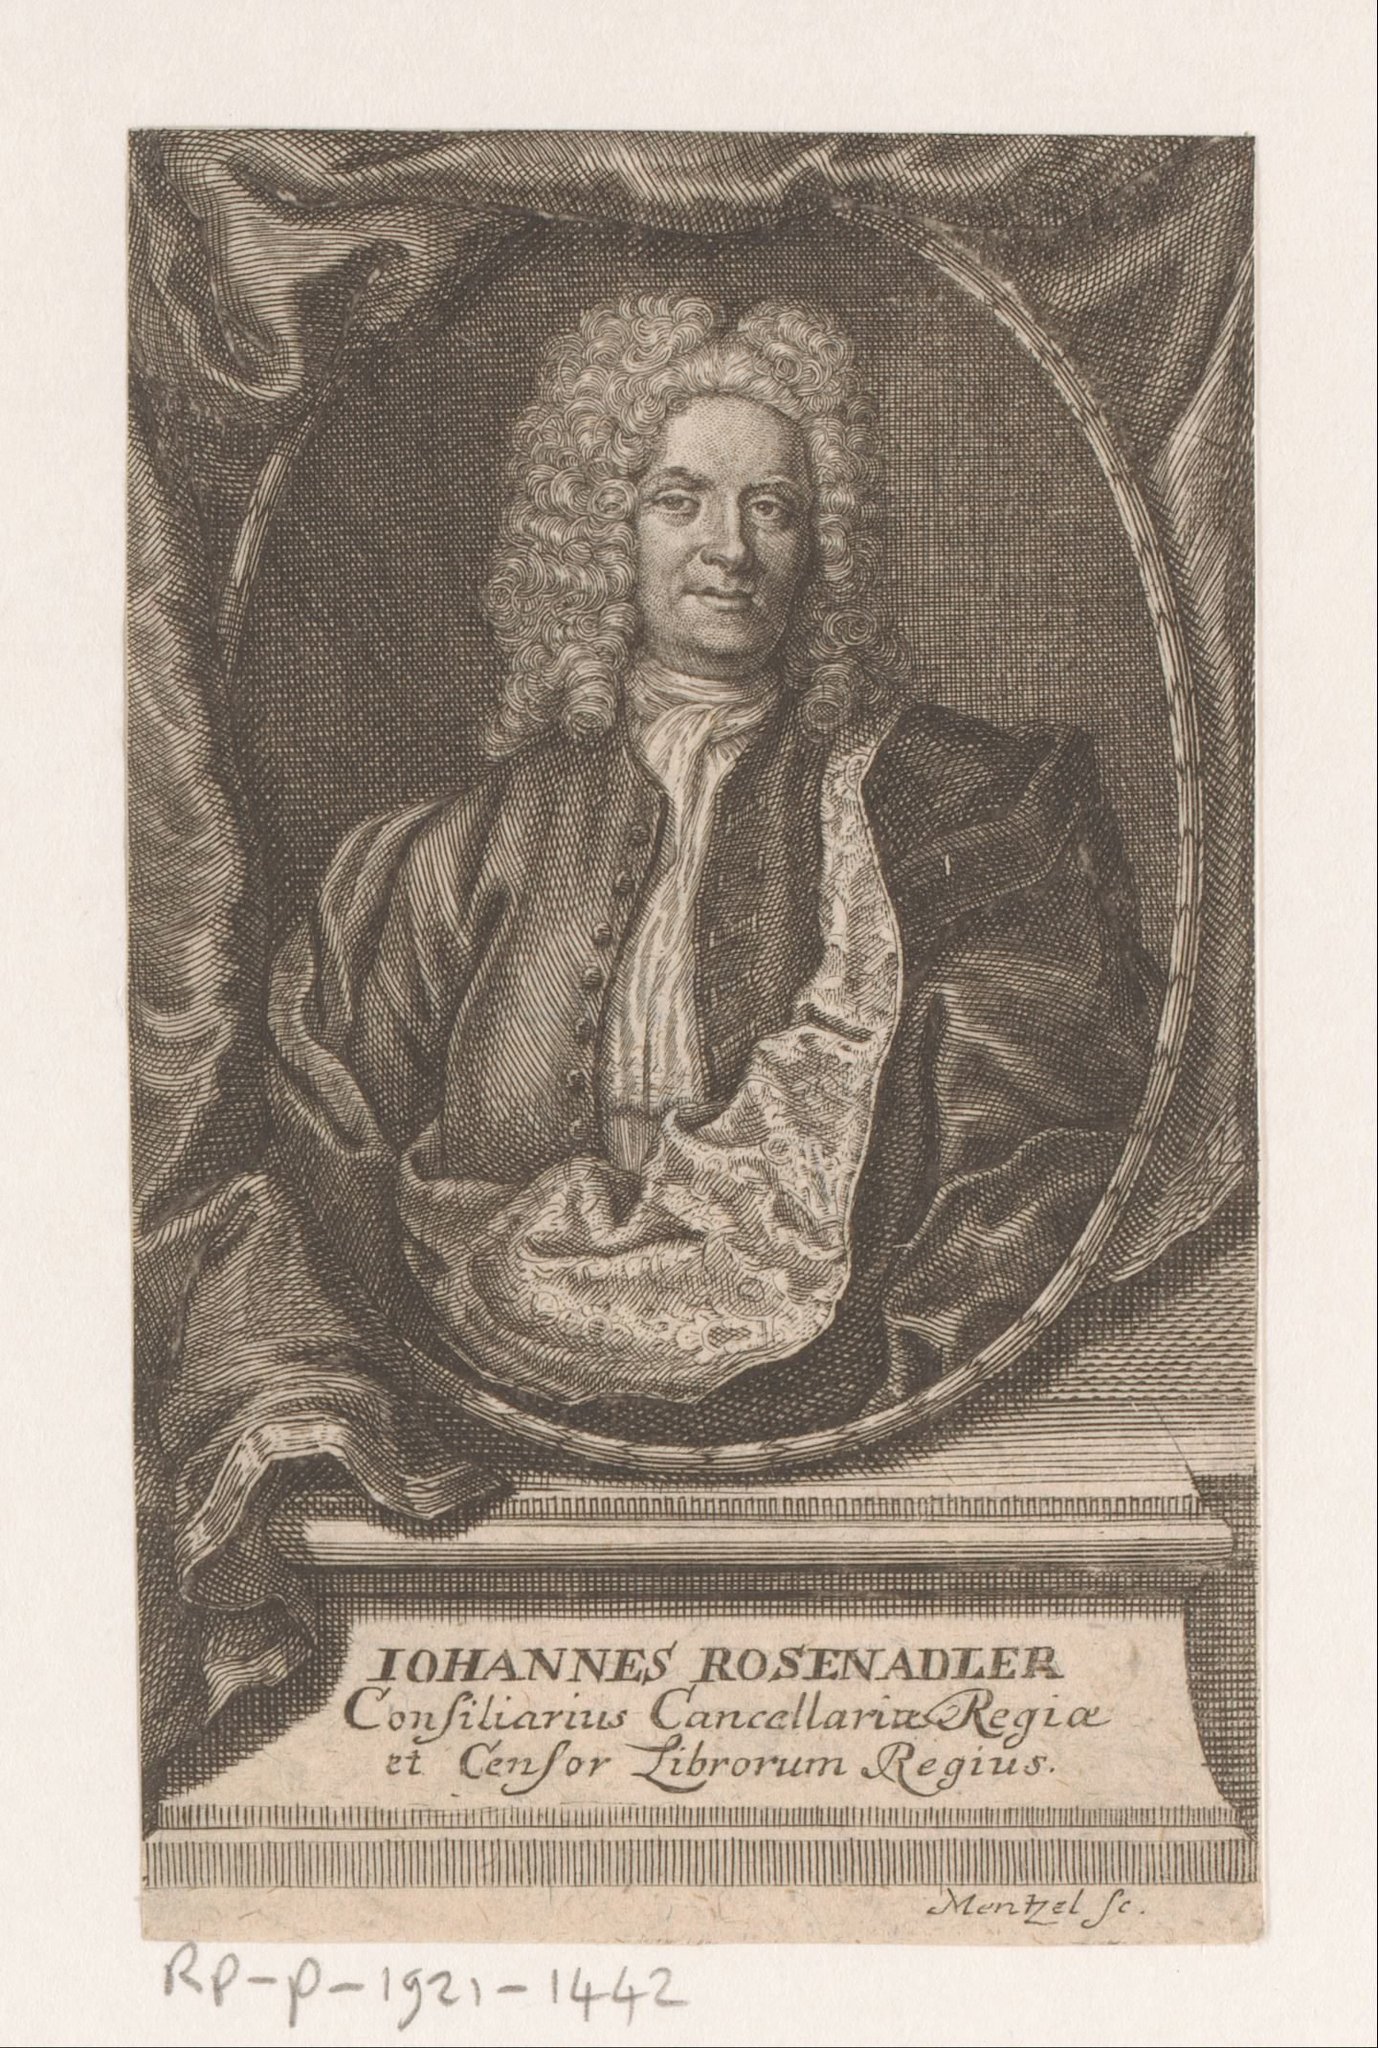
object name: print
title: Portret van Johan Upmarck af Rosenadler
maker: johann georg mentzel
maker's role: print maker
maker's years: 1677-1743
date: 1687-1743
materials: paper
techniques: engraving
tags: politician, historical persons, wig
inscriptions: collector's mark: Lugt 2233